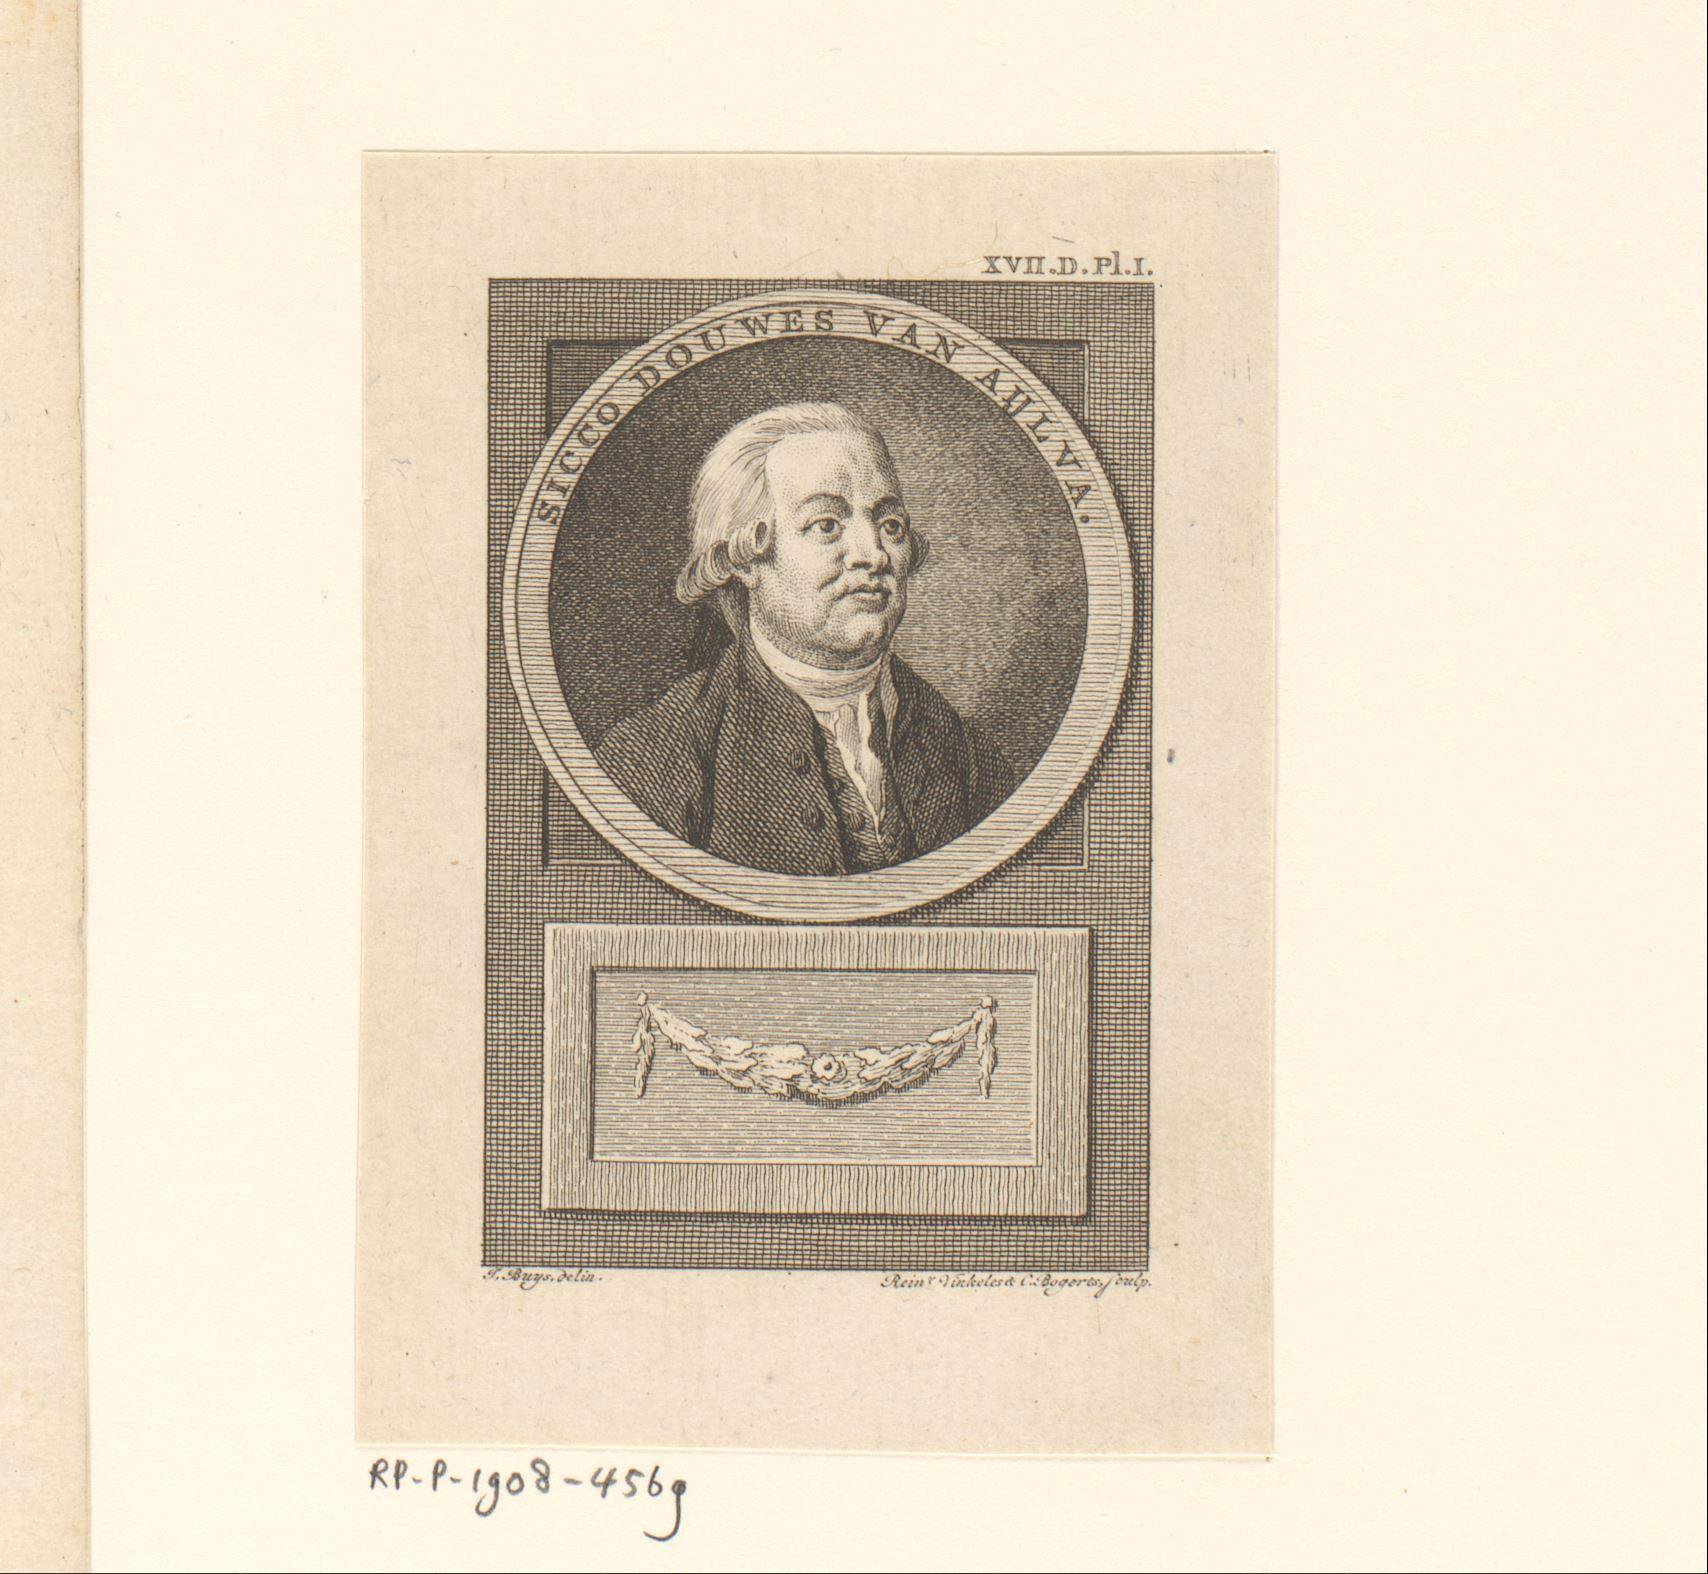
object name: print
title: Portret van de grietman Sicco Douwes van Aylva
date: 1787-1816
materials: paper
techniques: etching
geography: amsterdam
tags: holwerd, grietman, sicco douwe van aylva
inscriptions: collector's mark: Lugt 2228